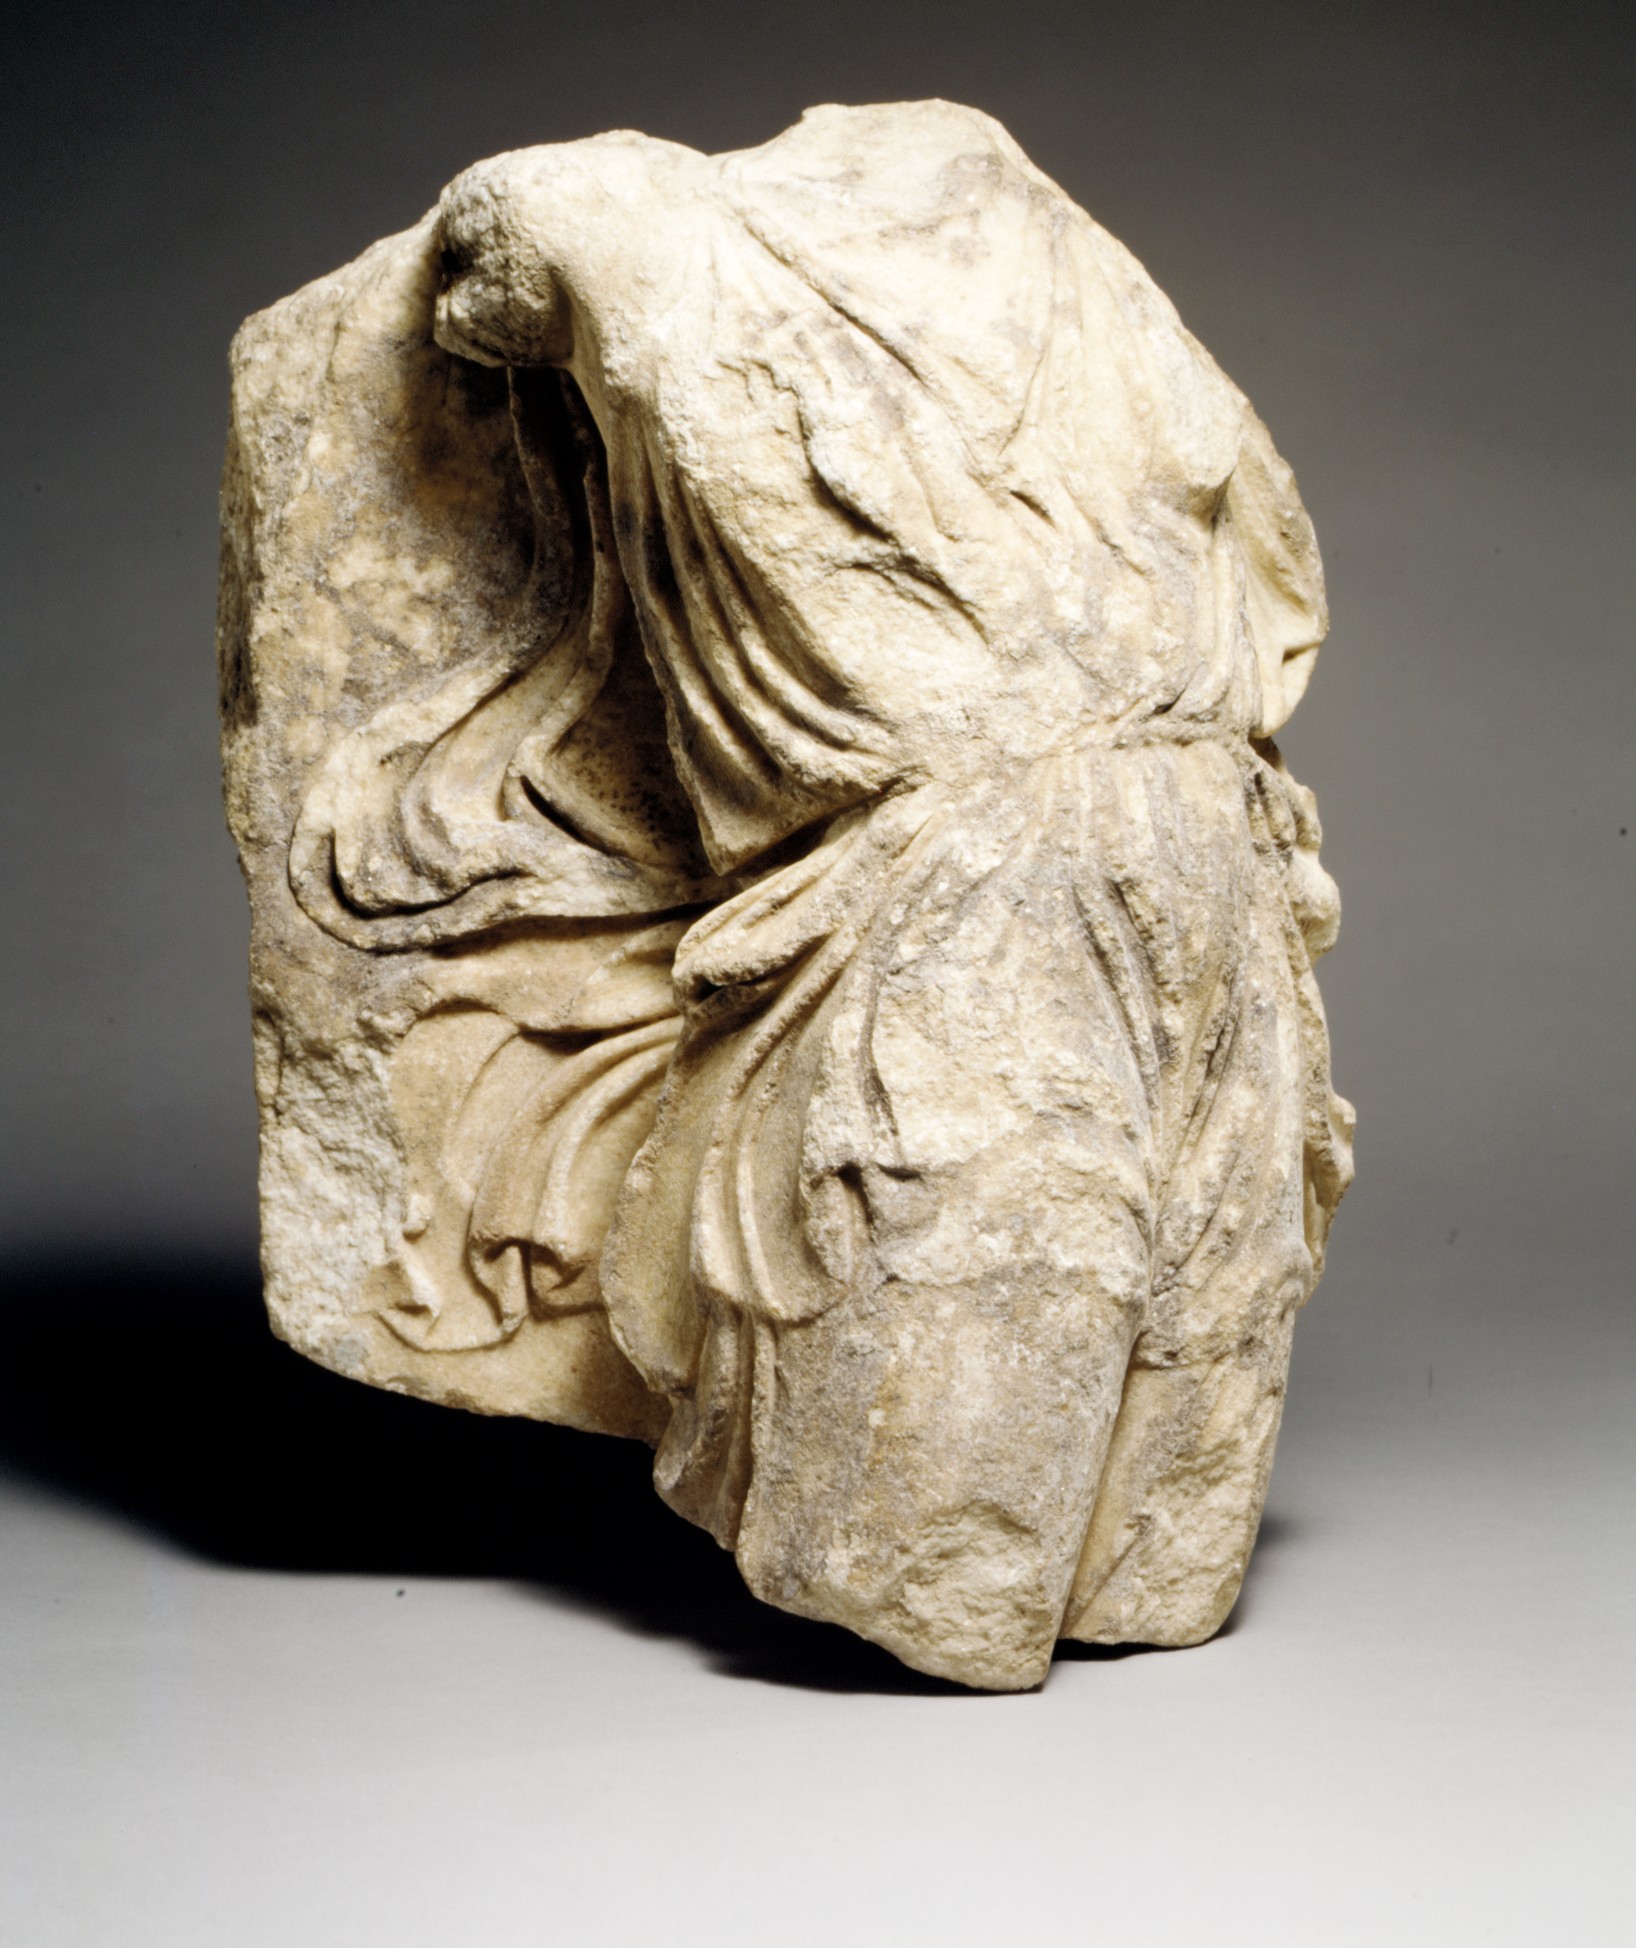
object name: relief fragment with nike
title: Fragment of a marble relief with a Nike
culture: greek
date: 434-401 BCE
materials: marble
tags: nike